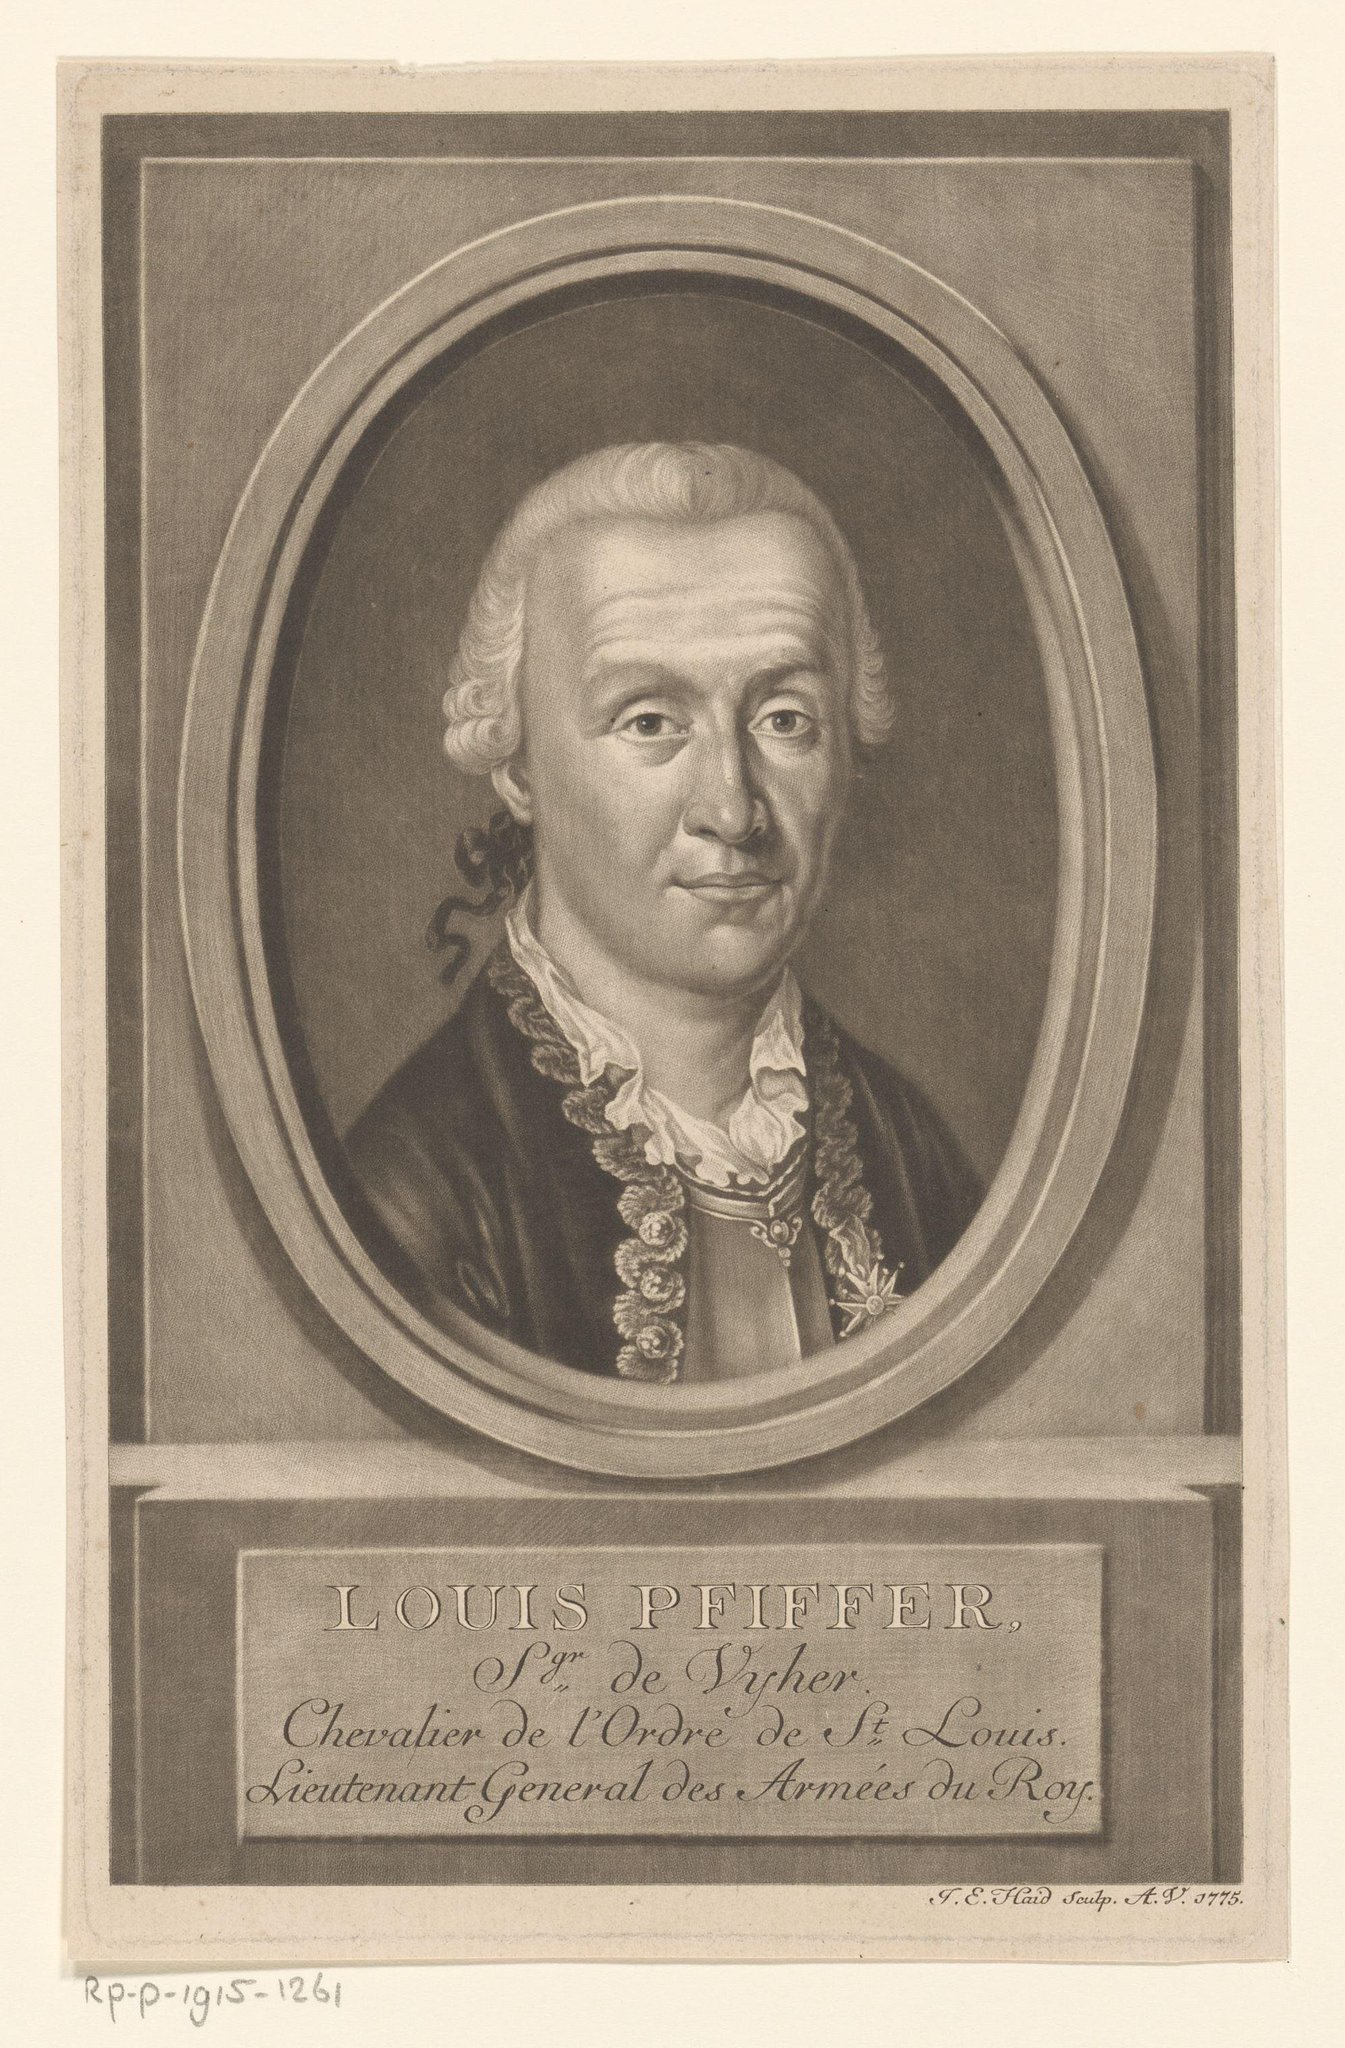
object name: print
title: Portret van Franz Ludwig Pfyffer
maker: johann elias haid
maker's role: print maker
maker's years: 1739-1809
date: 1775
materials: paper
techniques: mezzotint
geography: augsburg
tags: commander-in-chief, general, marshal, historical persons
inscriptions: collector's mark: Lugt 2228